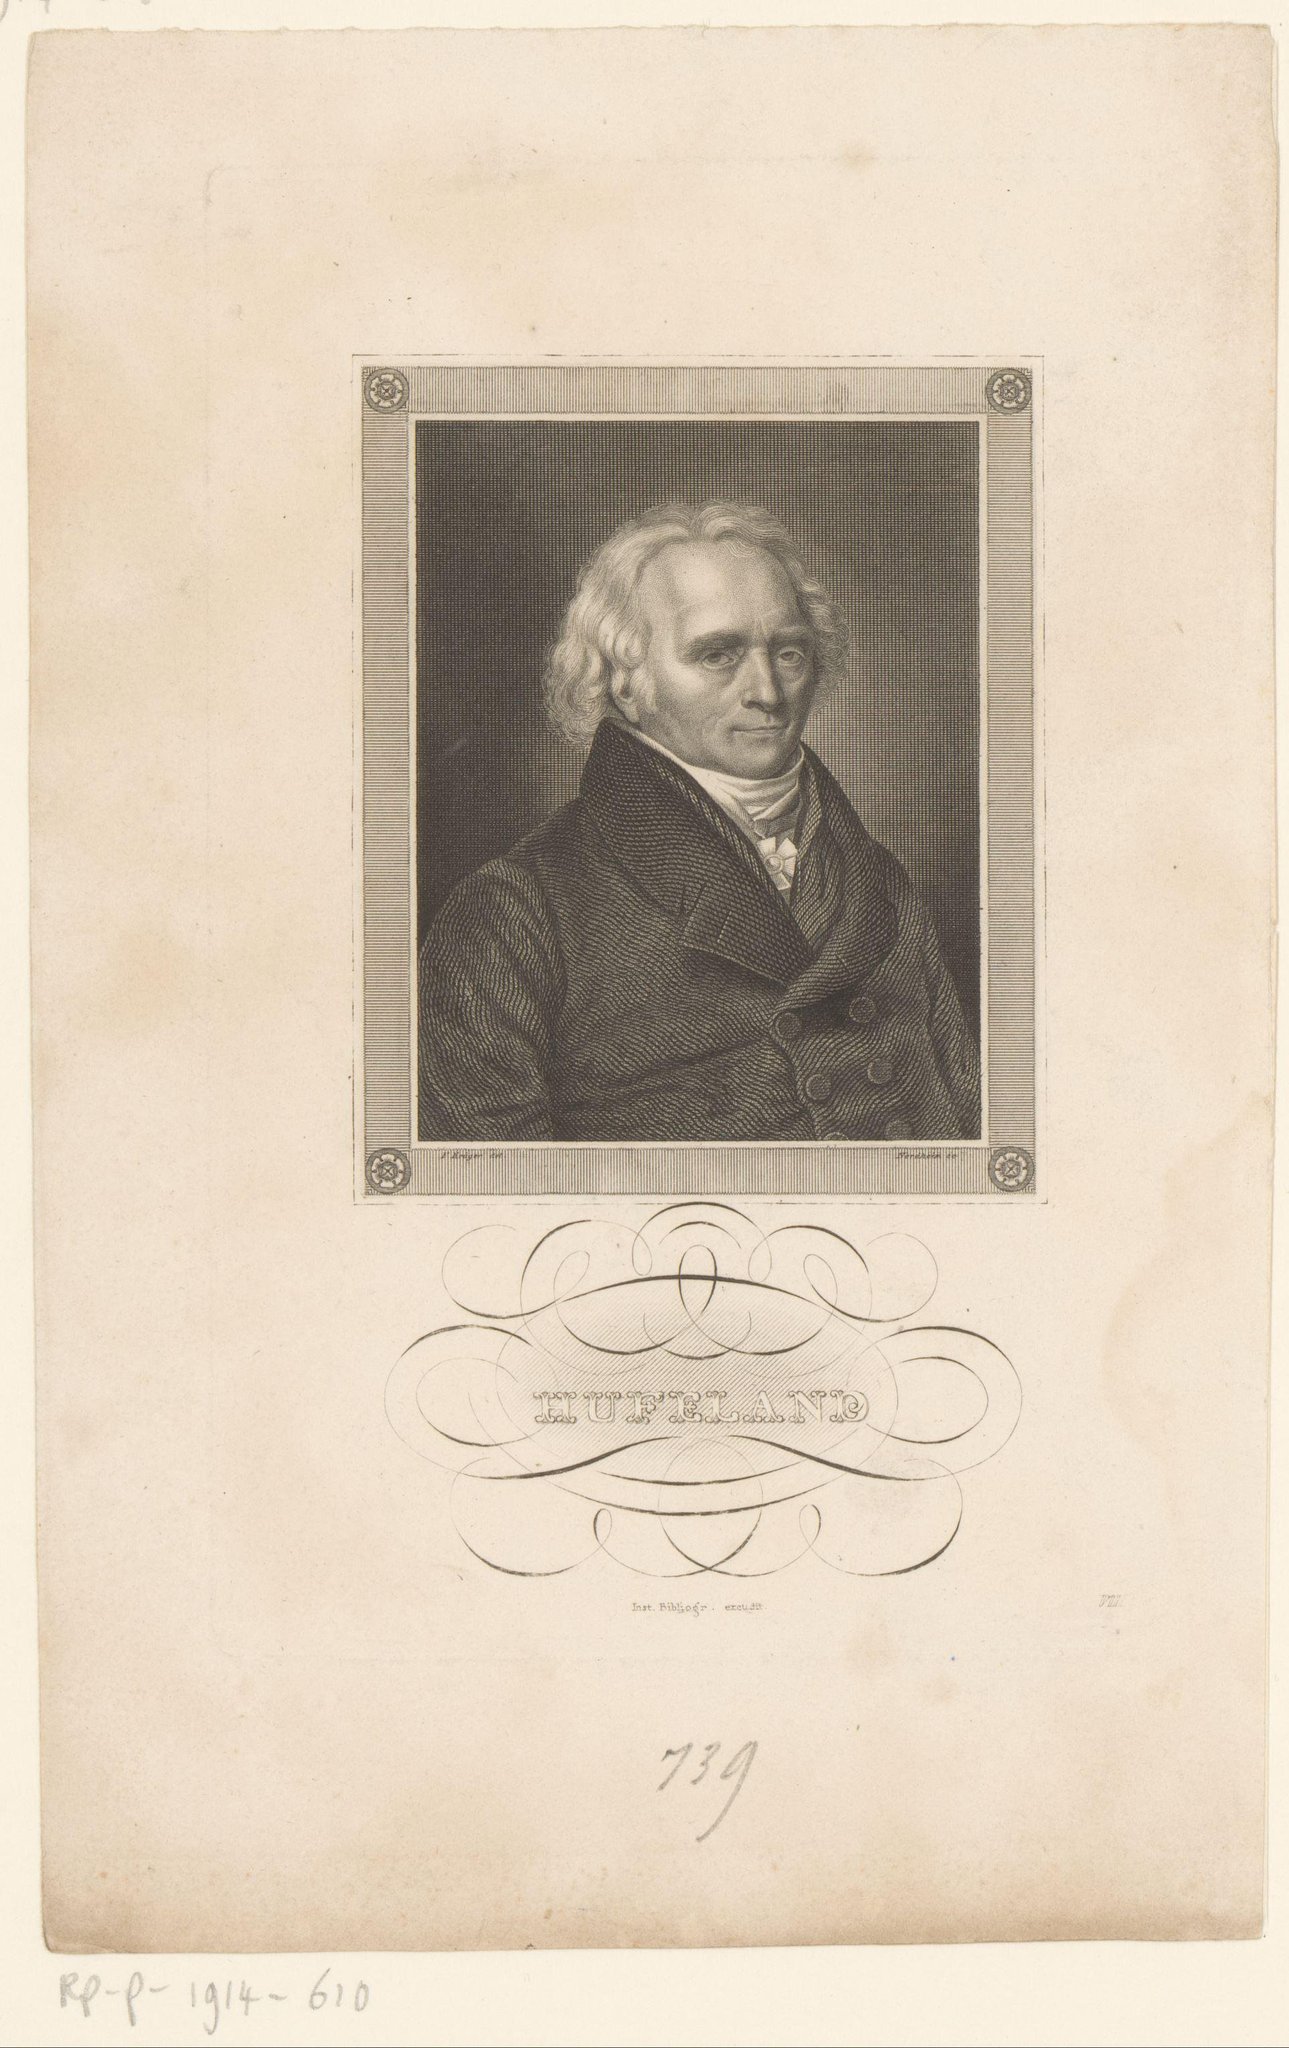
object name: print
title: Portret van Christoph Wilhelm von Hufeland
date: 1814-1829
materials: paper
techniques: etching, engraving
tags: berlin, historical persons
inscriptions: collector's mark: Lugt 2228